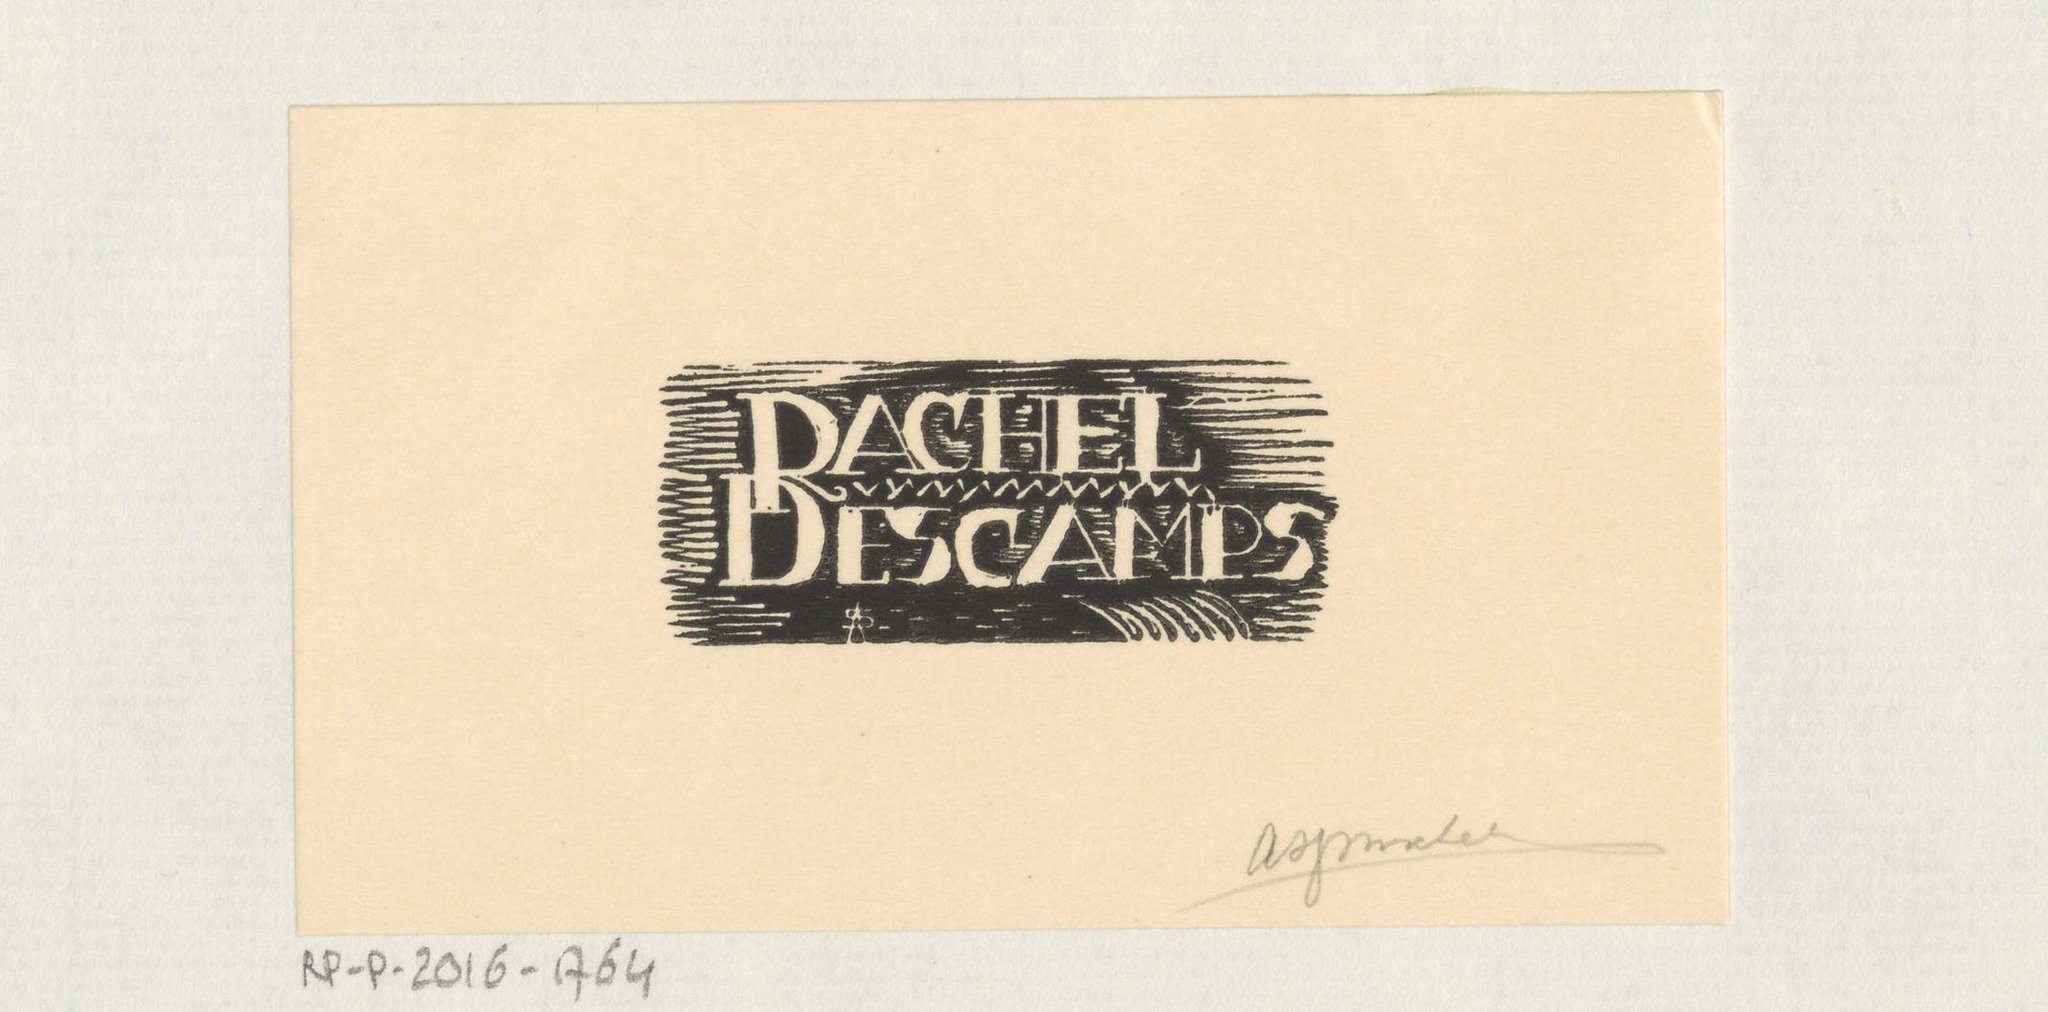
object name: bookplate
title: Ex libris van Rachel Descamps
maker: alph. schellart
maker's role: print maker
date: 1934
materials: paper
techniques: woodcut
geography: netherlands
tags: rachel descamps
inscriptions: workshop stamp: ‘a.i.j.m. schellart / houtsn 1934 No 59b’